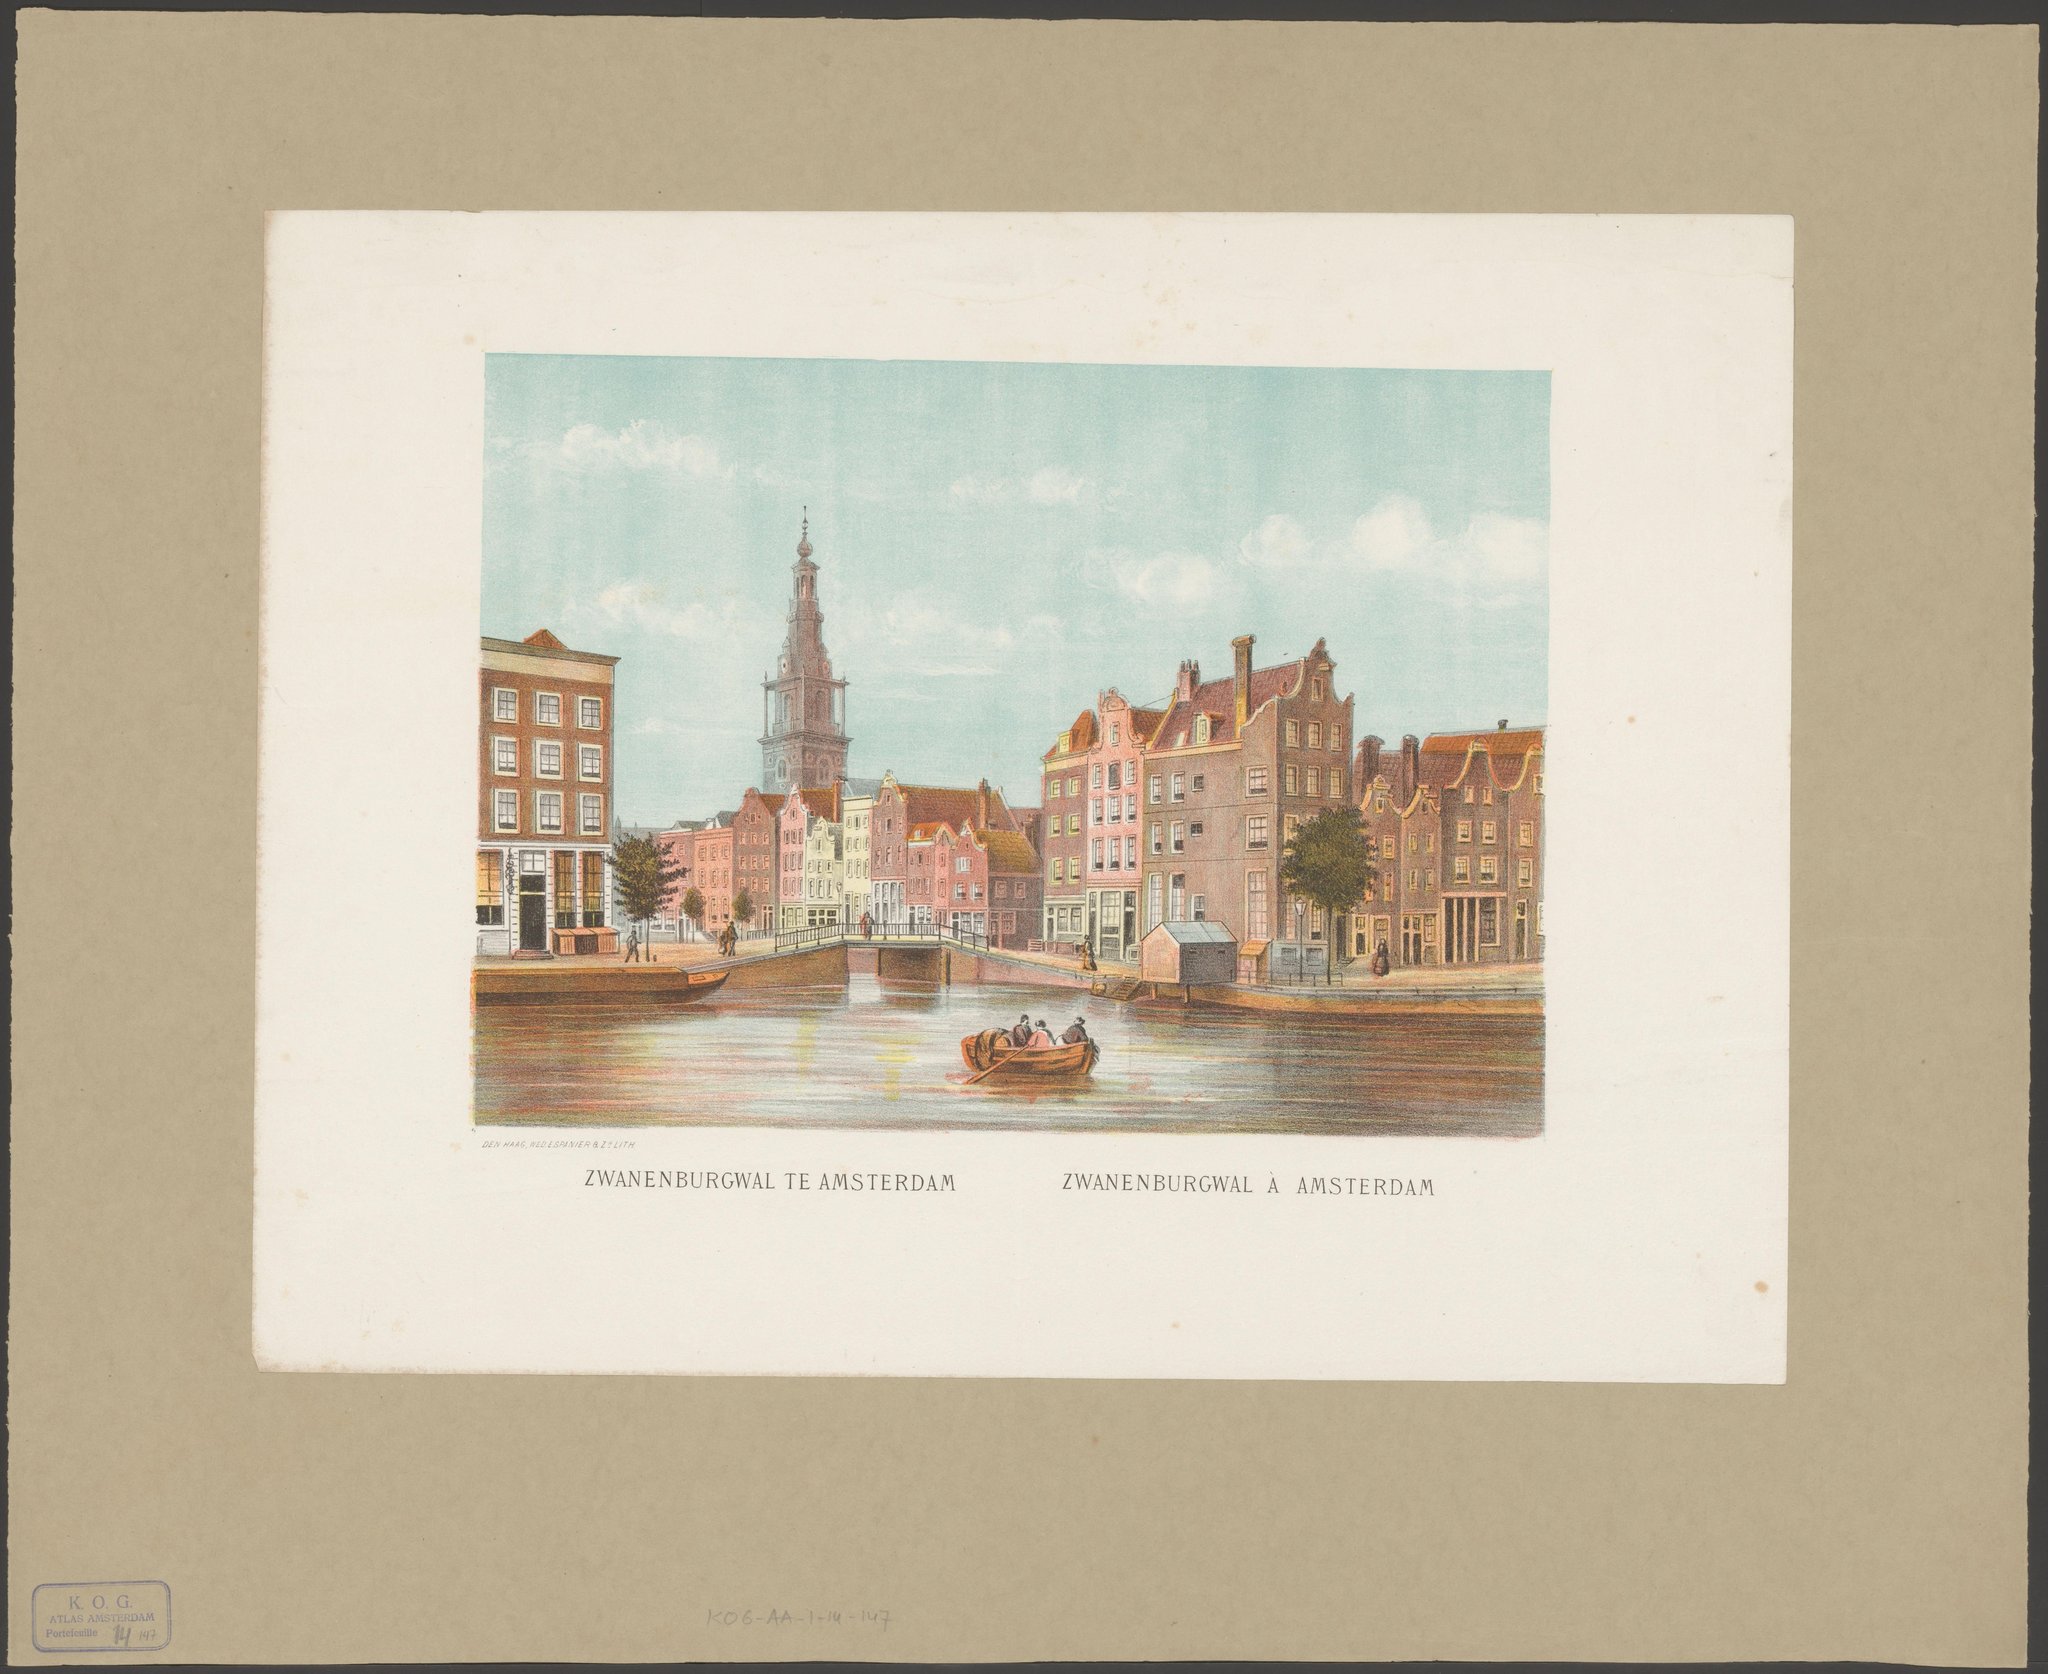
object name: print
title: Gezicht op de Zwanenburgwal met de Montelbaanstoren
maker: Anonymous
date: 1863-1883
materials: paper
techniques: lithograph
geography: the hague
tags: tower, clock tower ~ monumental adornment, city-view in general; 'veduta', canal, bridge in city across river, canal, etc.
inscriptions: collector's mark: ‘14 147’ Lugt 1641b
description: Onderwerpsrubriek binnen de Atlas Amsterdam: Zaagmolensloot, Zandpad, Zeeburg, Zeeburgerdijk, Zeeburgerpad, Zeeburgerstraat, Zwanenburgwal, Zwartebijlsteeg.